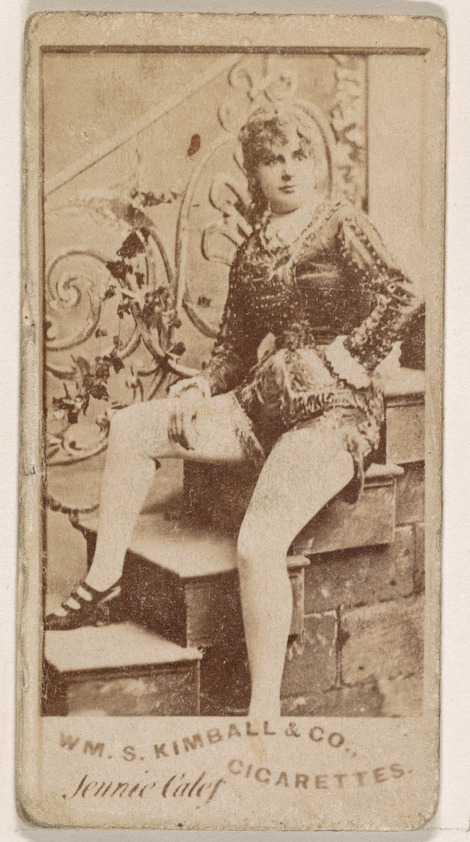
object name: photograph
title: Jennie Calef, from the Actresses series (N203) issued by Wm. S. Kimball & Co.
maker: william s. kimball & company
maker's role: publisher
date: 1889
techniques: color lithograph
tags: portraits,women,actresses